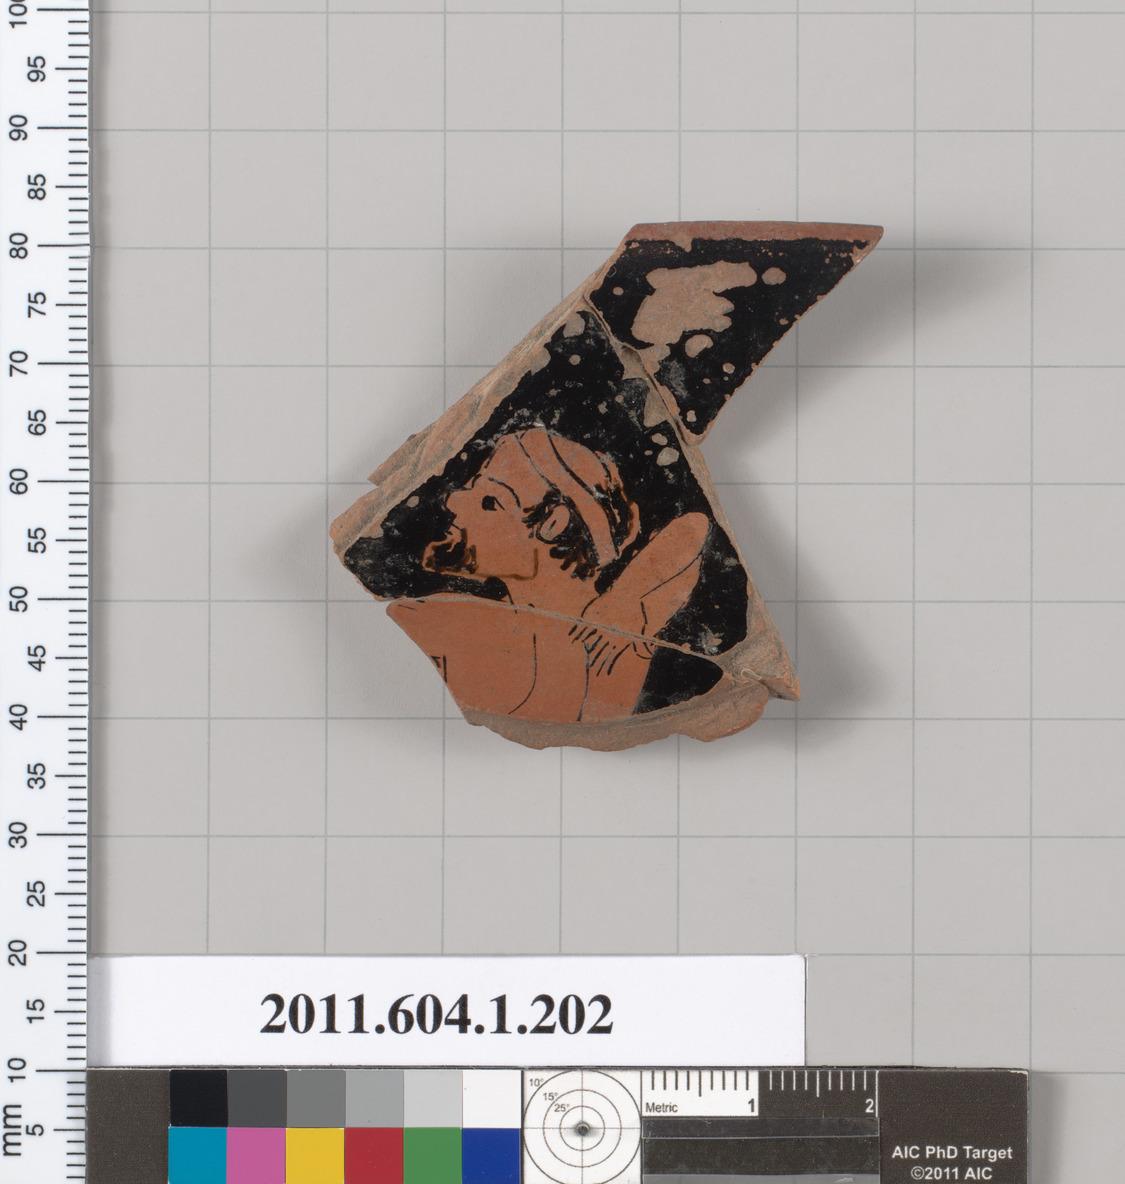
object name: kylix fragment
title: Terracotta fragment of a kylix (drinking cup)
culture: greek, attic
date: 475-451 BCE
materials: terracotta